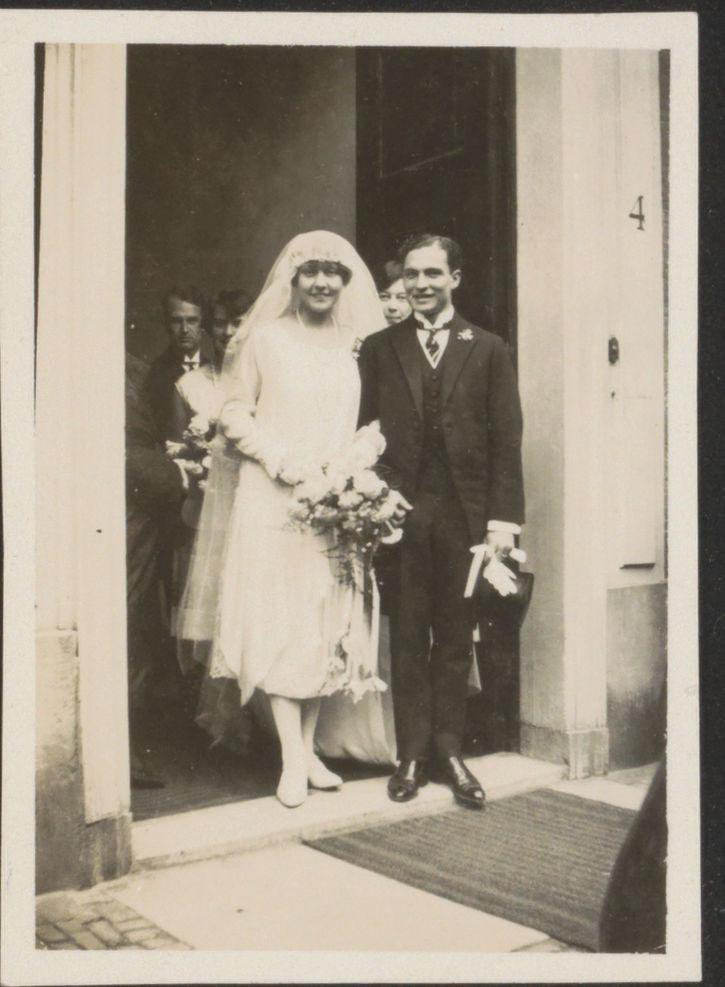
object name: photograph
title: Huwelijksportret van een leerling van de Koloniale School voor Meisjes en Vrouwen te 's-Gravenhage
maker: Anonymous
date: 1920-1930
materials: photographic support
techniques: photography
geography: netherlands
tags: bride and groom in wedding-dress, netherlands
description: Onderdeel van Stamboek van de leerlingen der Koloniale School voor Meisjes en Vrouwen te 's-Gravenhage deel I (1921-1929).